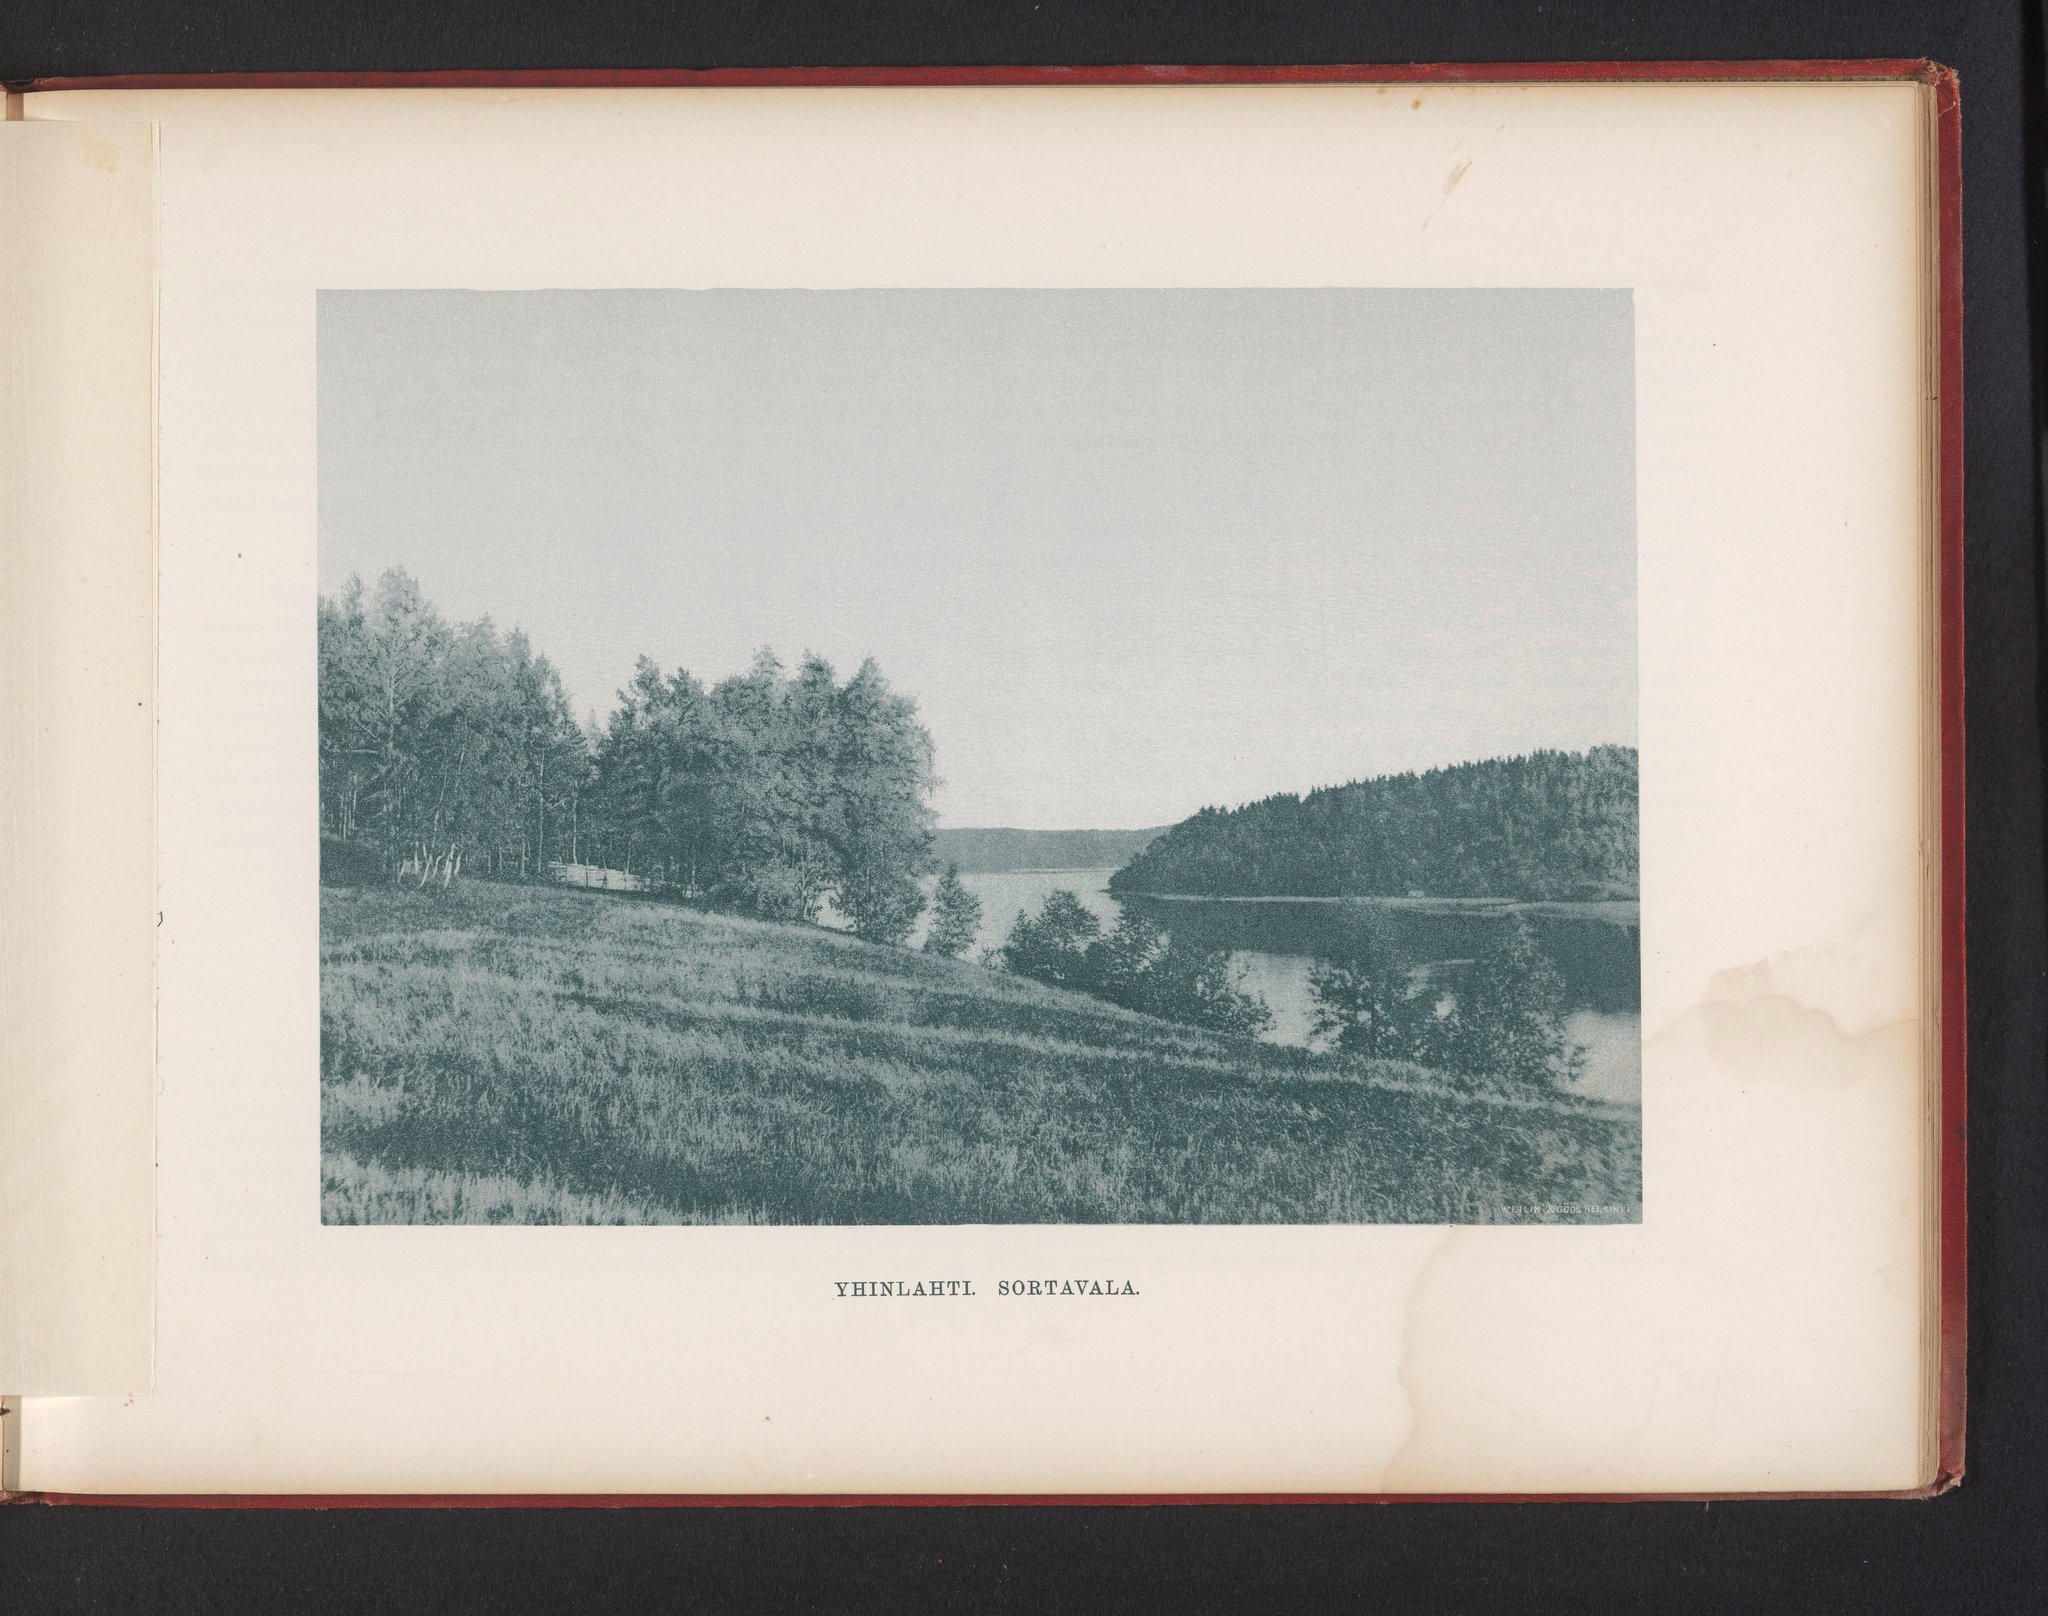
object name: photomechanical print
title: Yhinlahti Sortavalan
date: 1888-1893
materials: paper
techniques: autotype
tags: trees, landscapes with waters, waterscapes, seascapes (in the temperate zone)